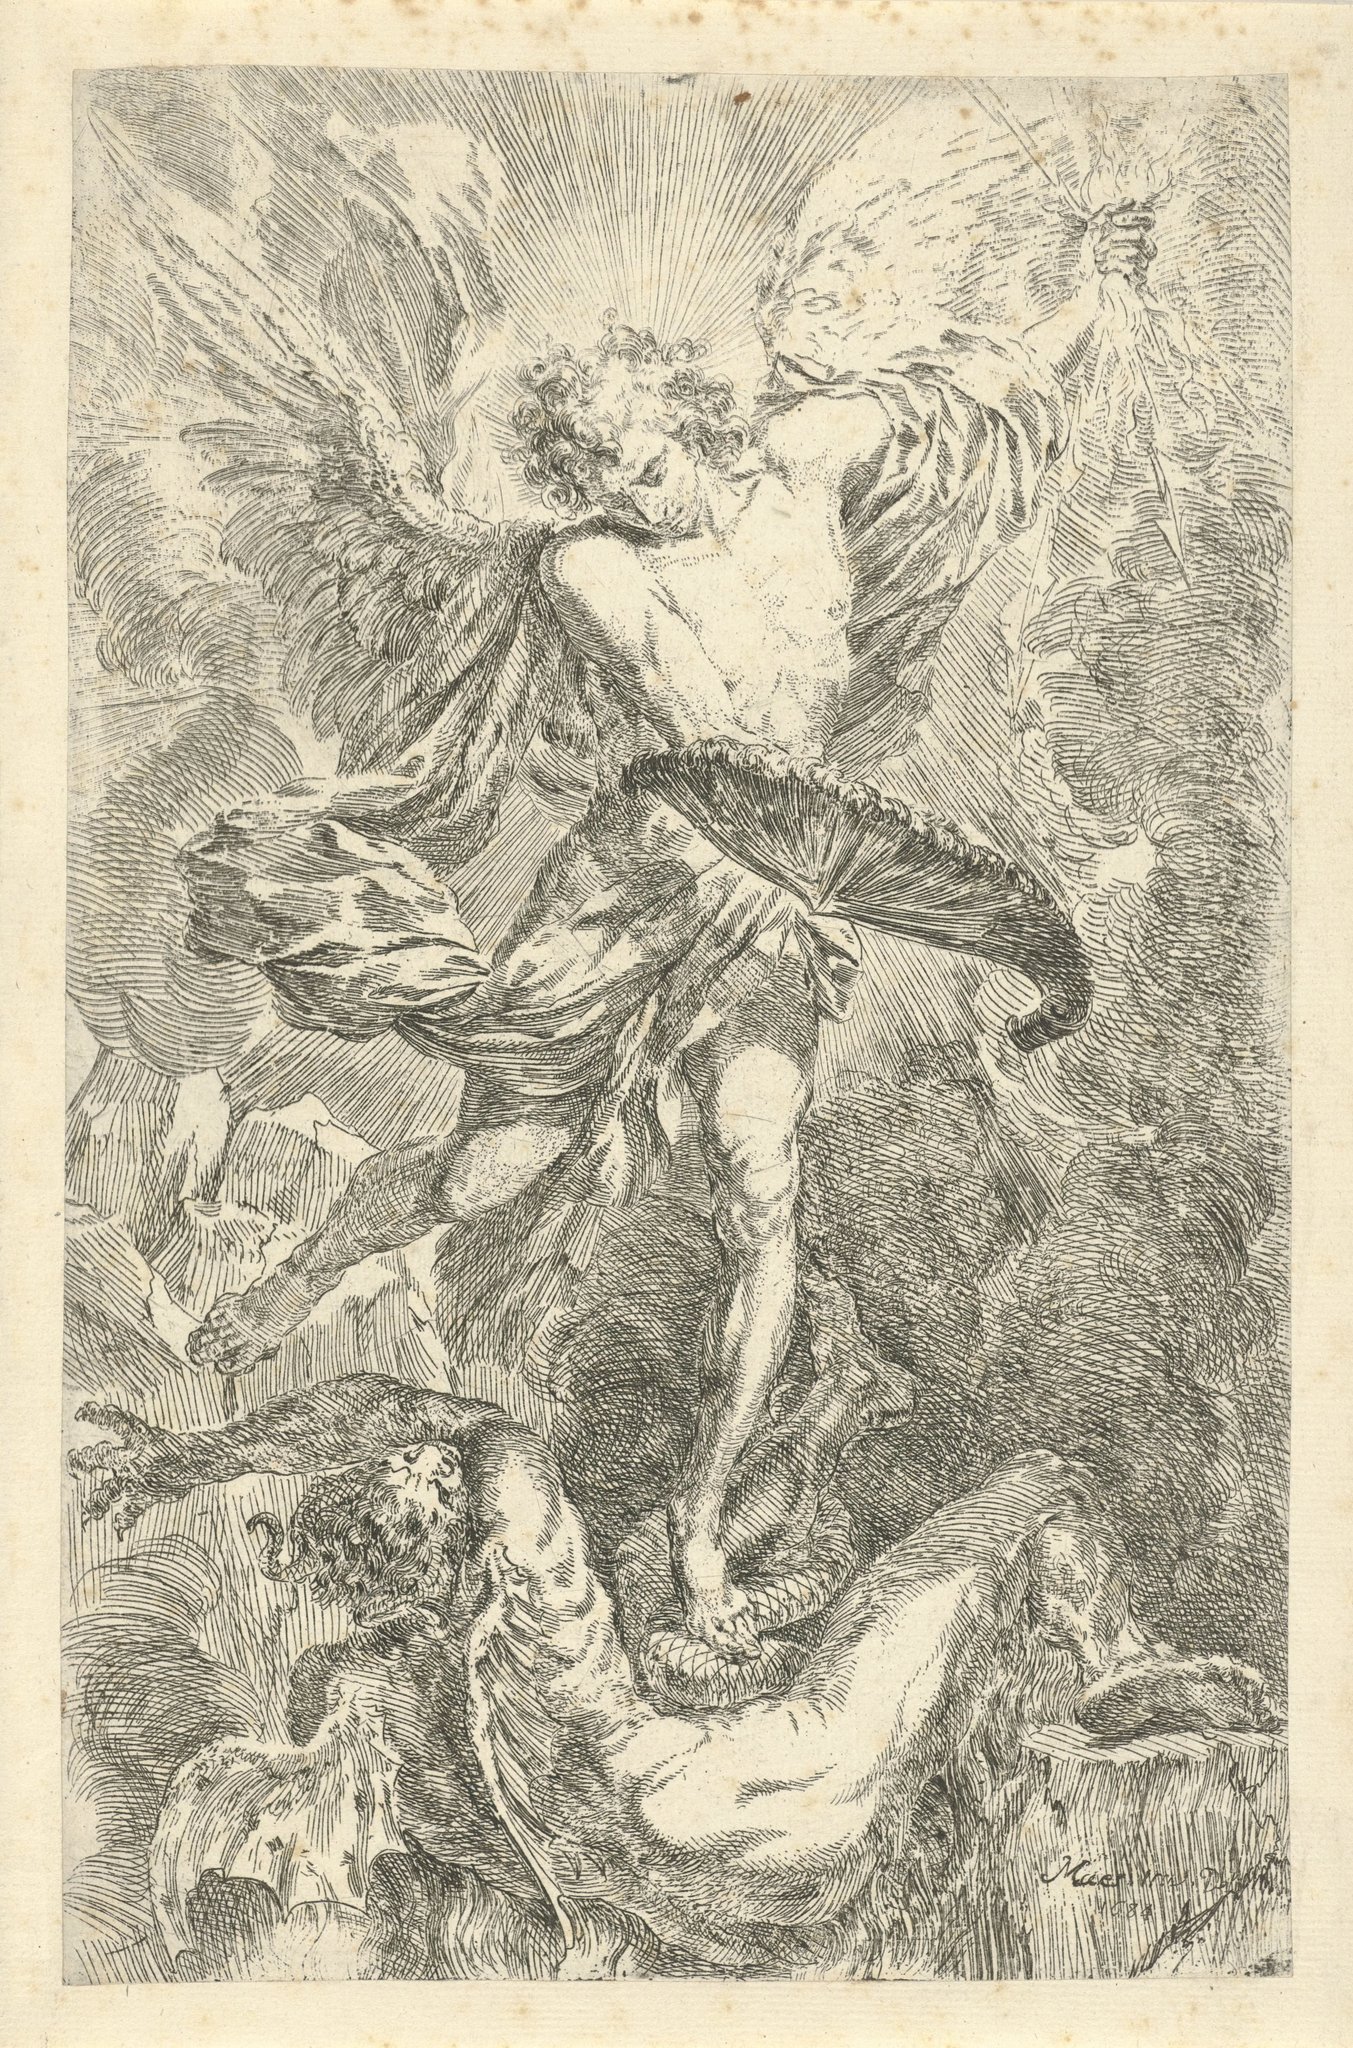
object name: print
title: Aartsengel Michaël doodt de draak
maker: godfried maes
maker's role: draughtsman, painter, print maker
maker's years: 1649-1700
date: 1684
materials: paper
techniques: etching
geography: antwerp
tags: the archangel michael fighting the dragon (devil, satan)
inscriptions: collector's mark: Lugt 240